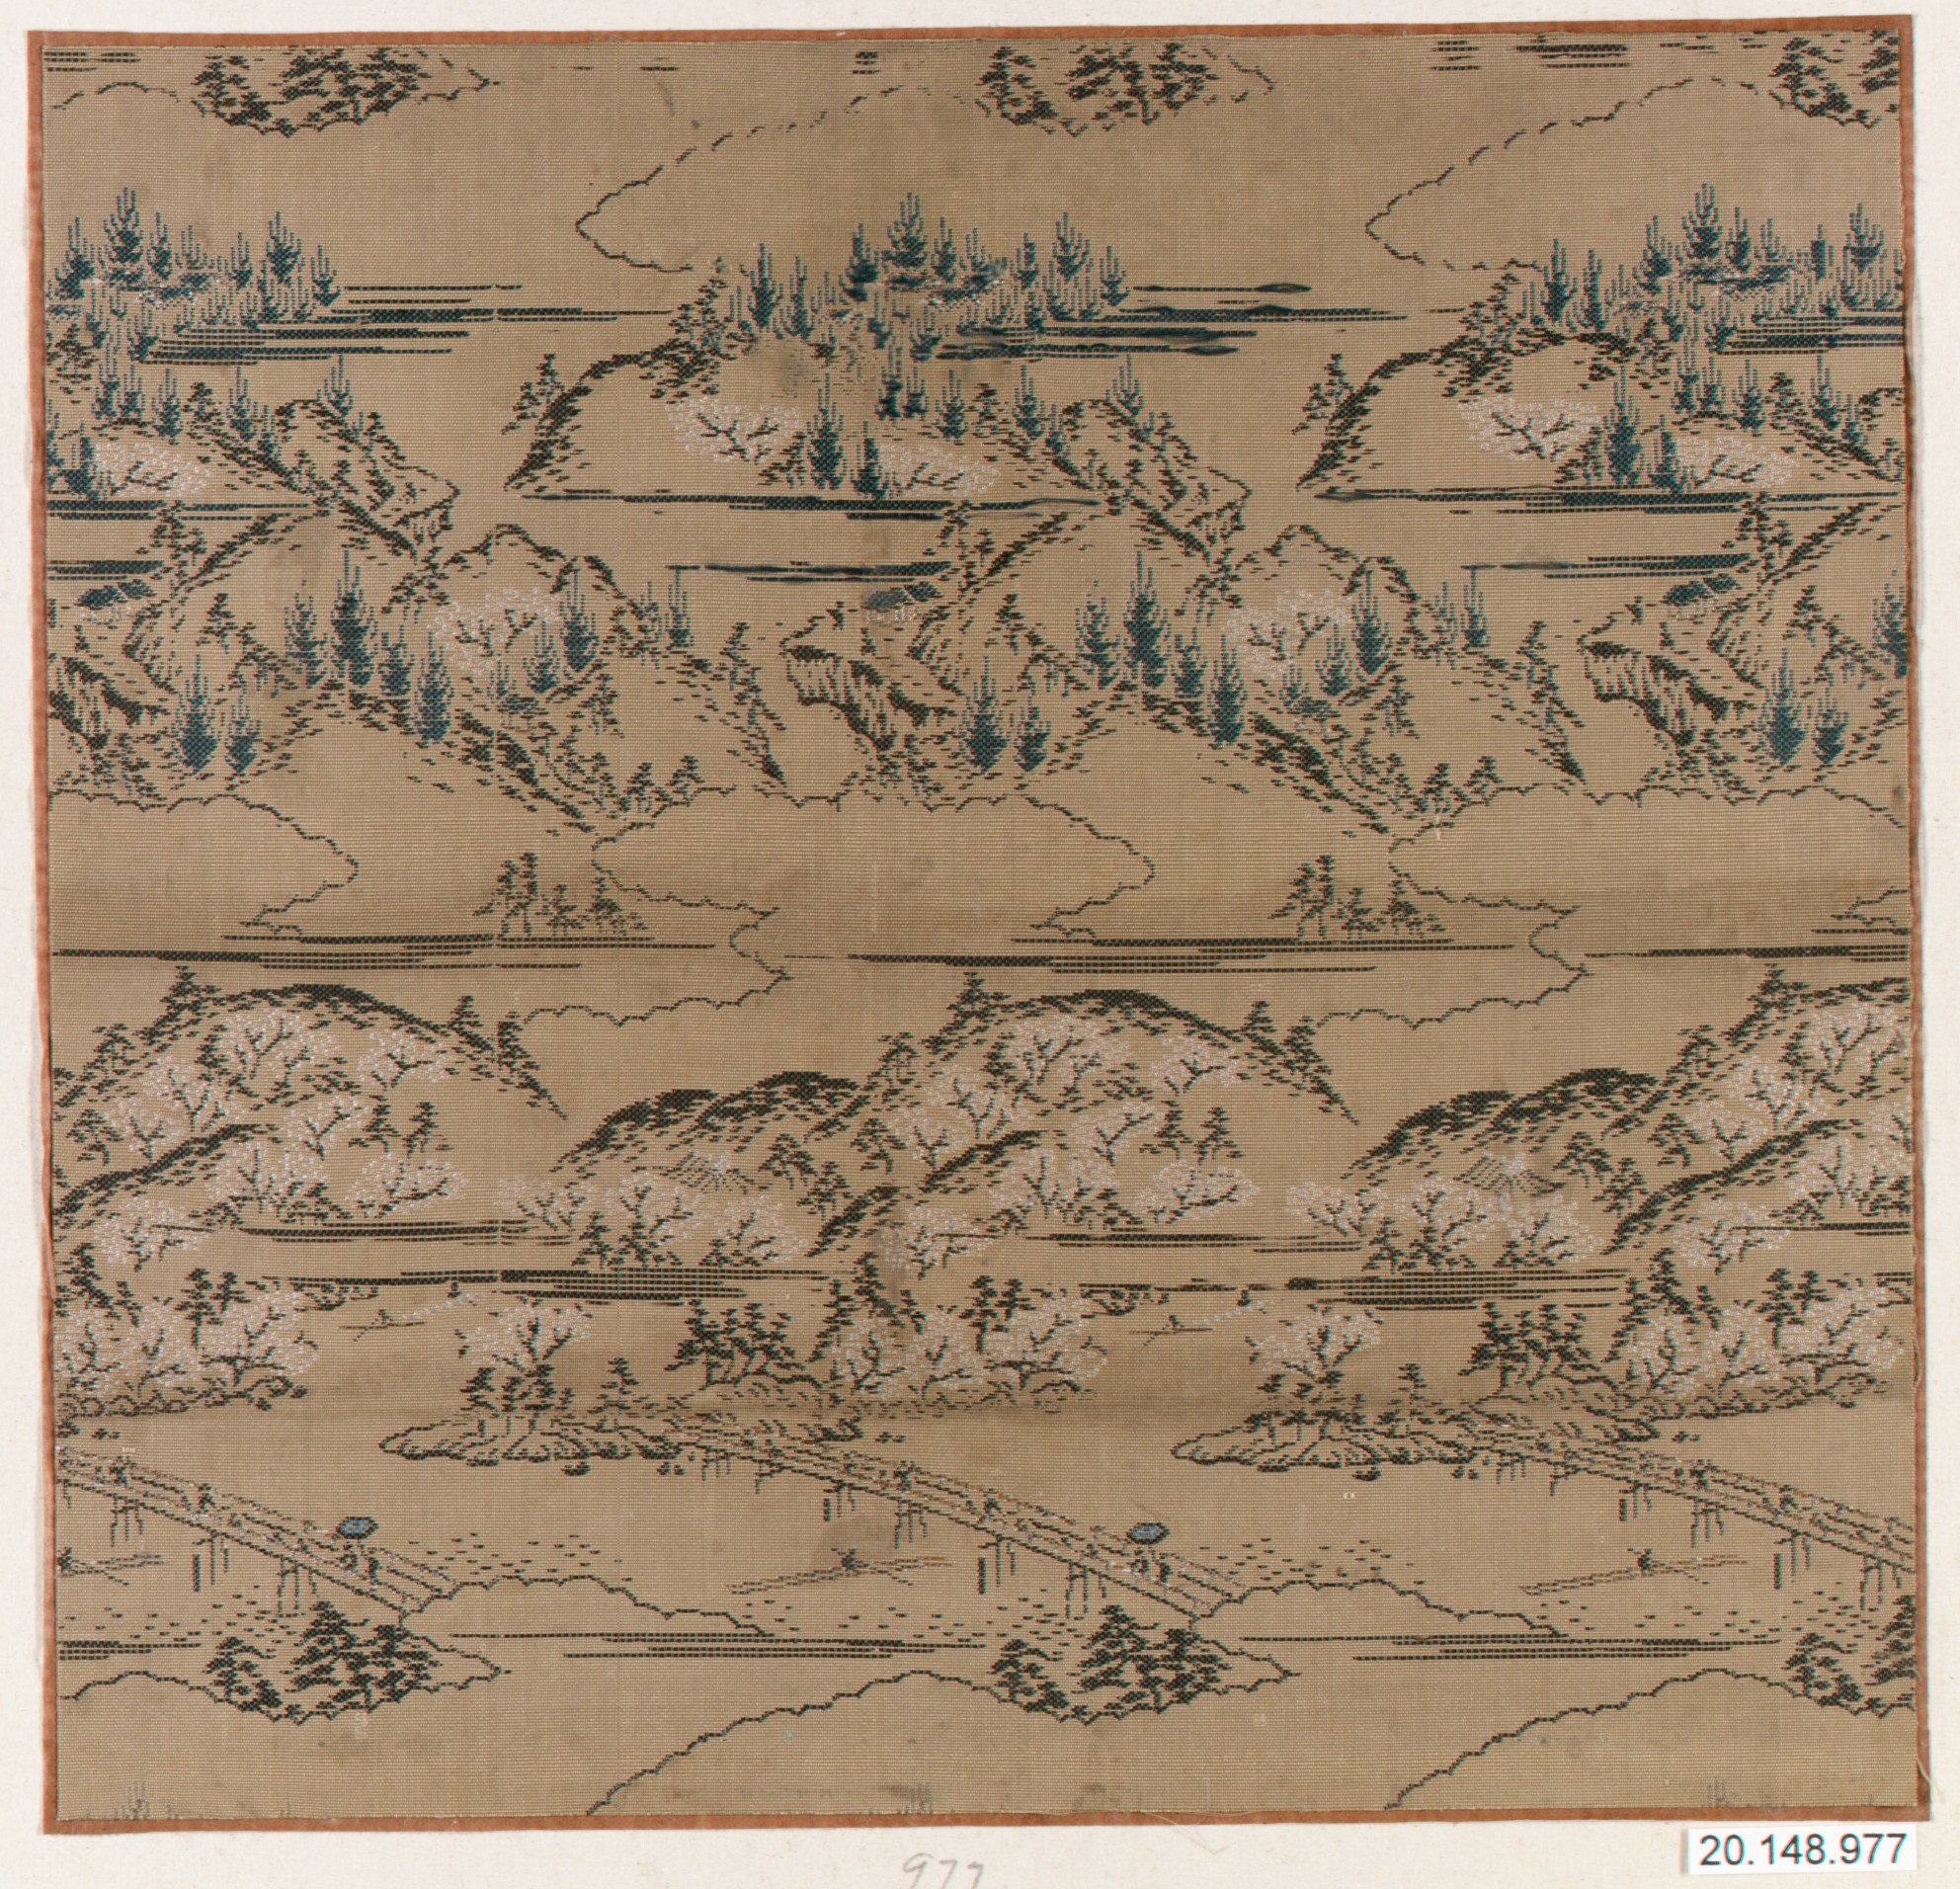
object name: piece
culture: japanese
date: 1701-1800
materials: silk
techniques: compound weave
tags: bridges,trees